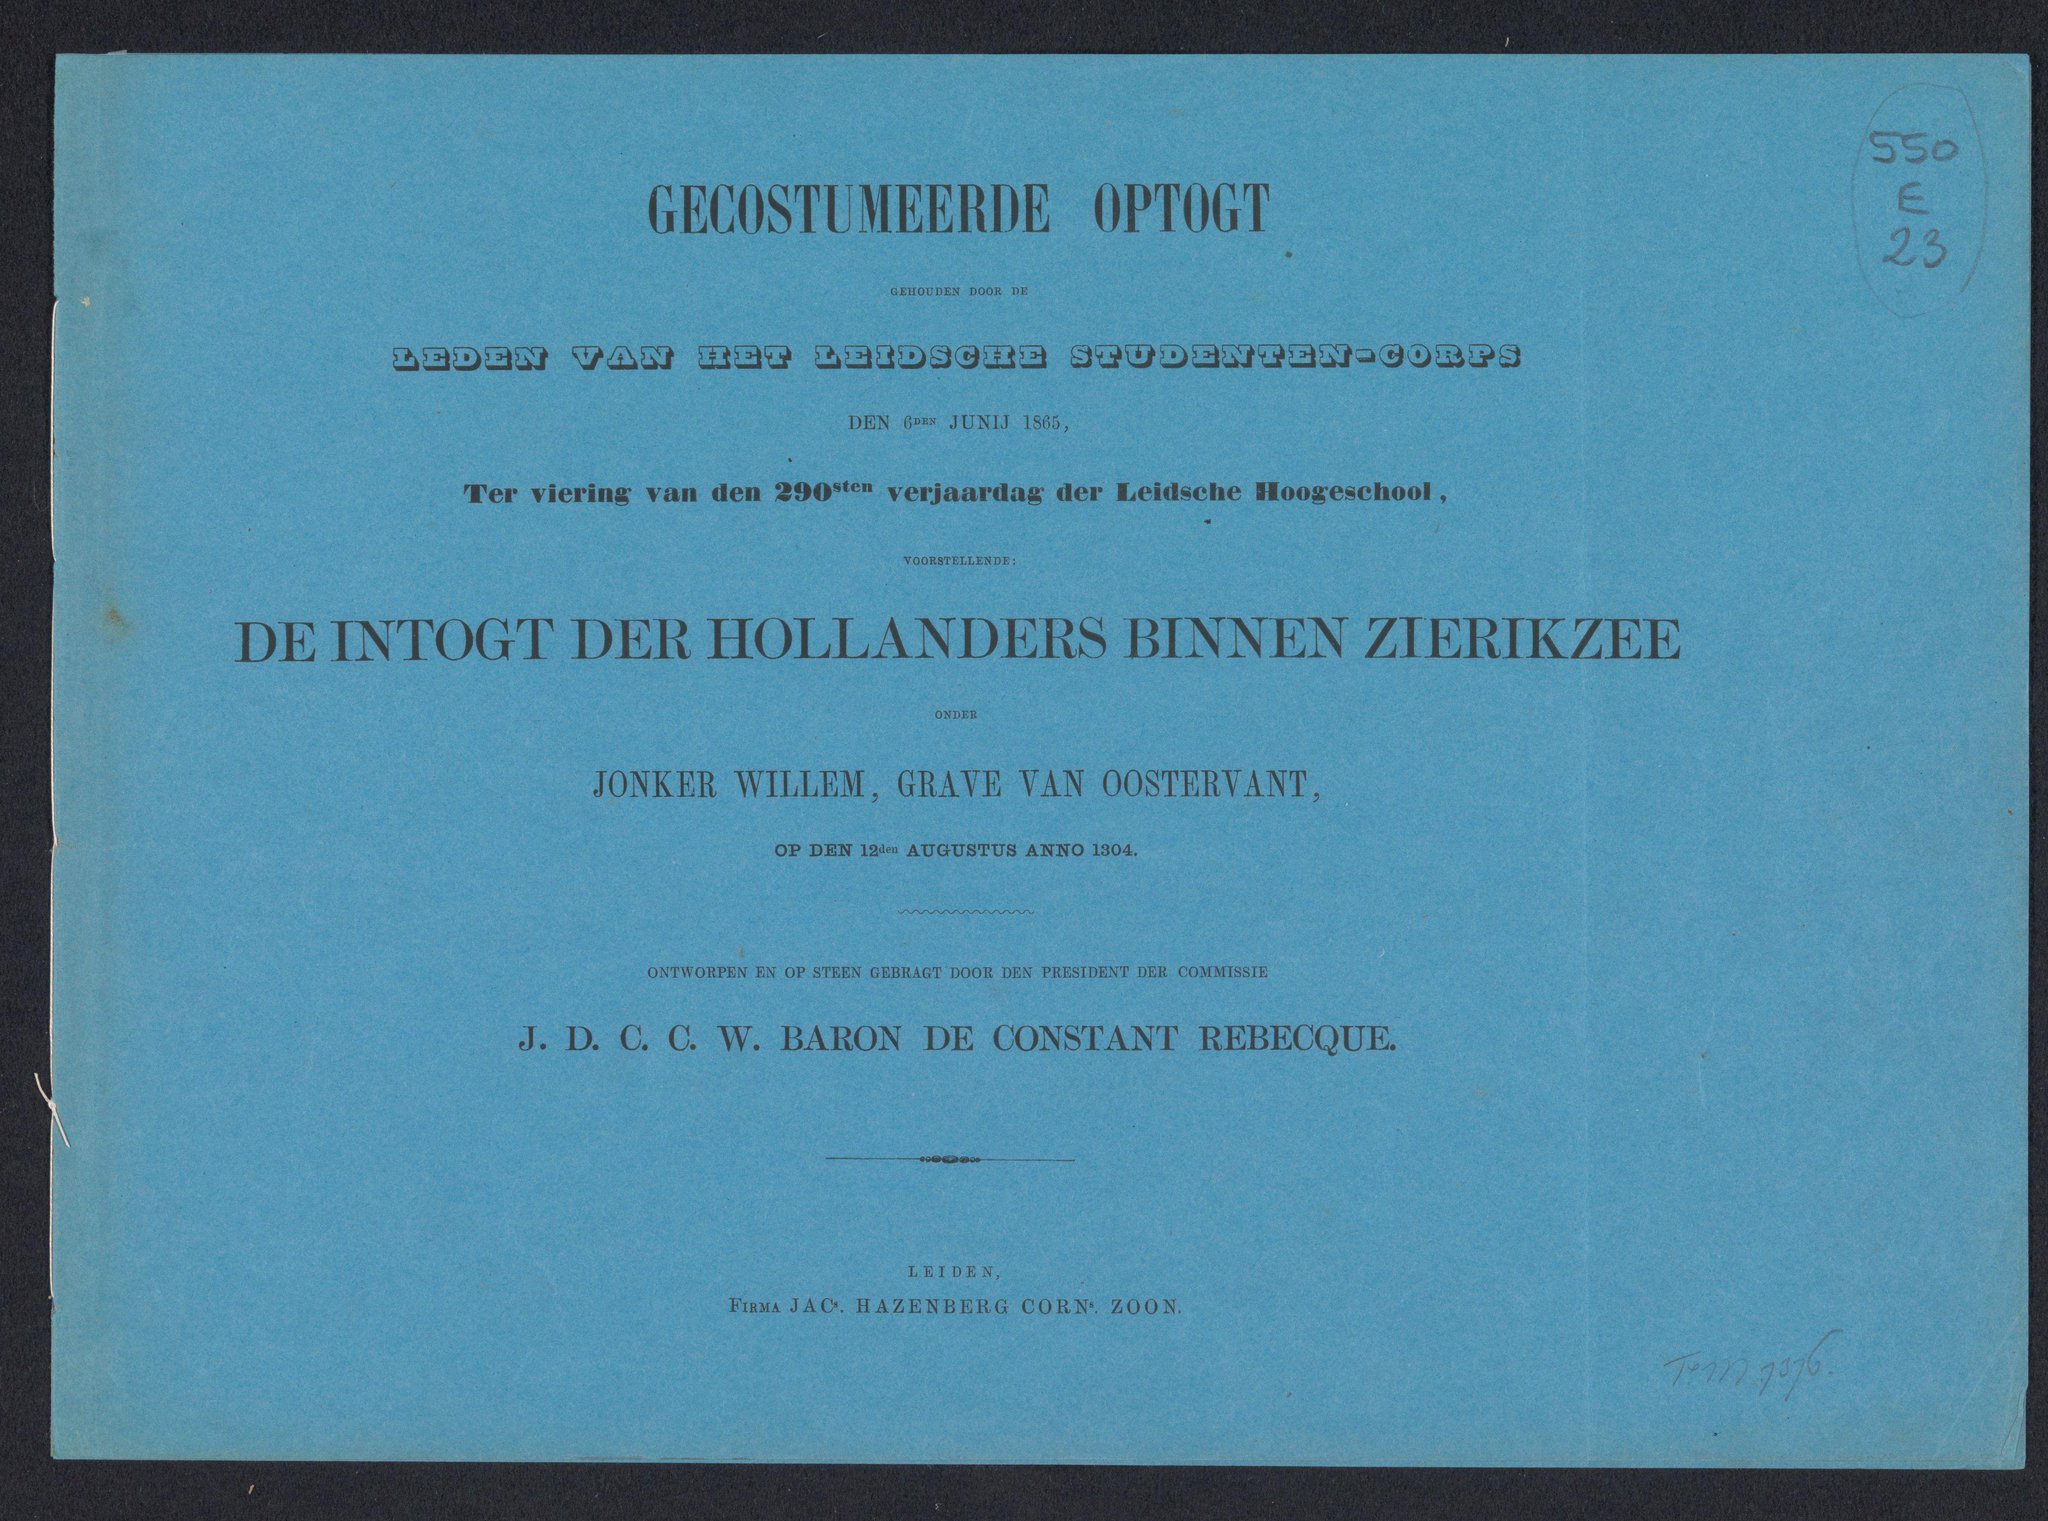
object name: text sheet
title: Gecostumeerde optogt gehouden door de leden van het Leidsche studenten-corps den 6den Junij 1865, ter viering van den 290sten verjaardag der Leidsche Hoogeschool, voorstellende: de intogt der Hollanders binnen Zierikzee onder Jonker Willem, Grave van Oostervant, op den 12den augustus Anno 1304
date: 1865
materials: paper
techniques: letterpress printing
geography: leiden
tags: leiden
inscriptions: collector's mark: Lugt 2166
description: Historische gekostumeerde optocht van de studenten van de Leidse Hogeschool gehouden op 6 juni 1865 ter gelegenheid van het 290-jarig bestaan van de Hogeschool. De optocht verbeeldt de intocht van de Hollanders binnen Zierikzee op 12 augustus 1304. Boekje van acht bladzijden met een voorbericht en de legenda behorend bij de serie van 16 aaneen geplakte bladen.